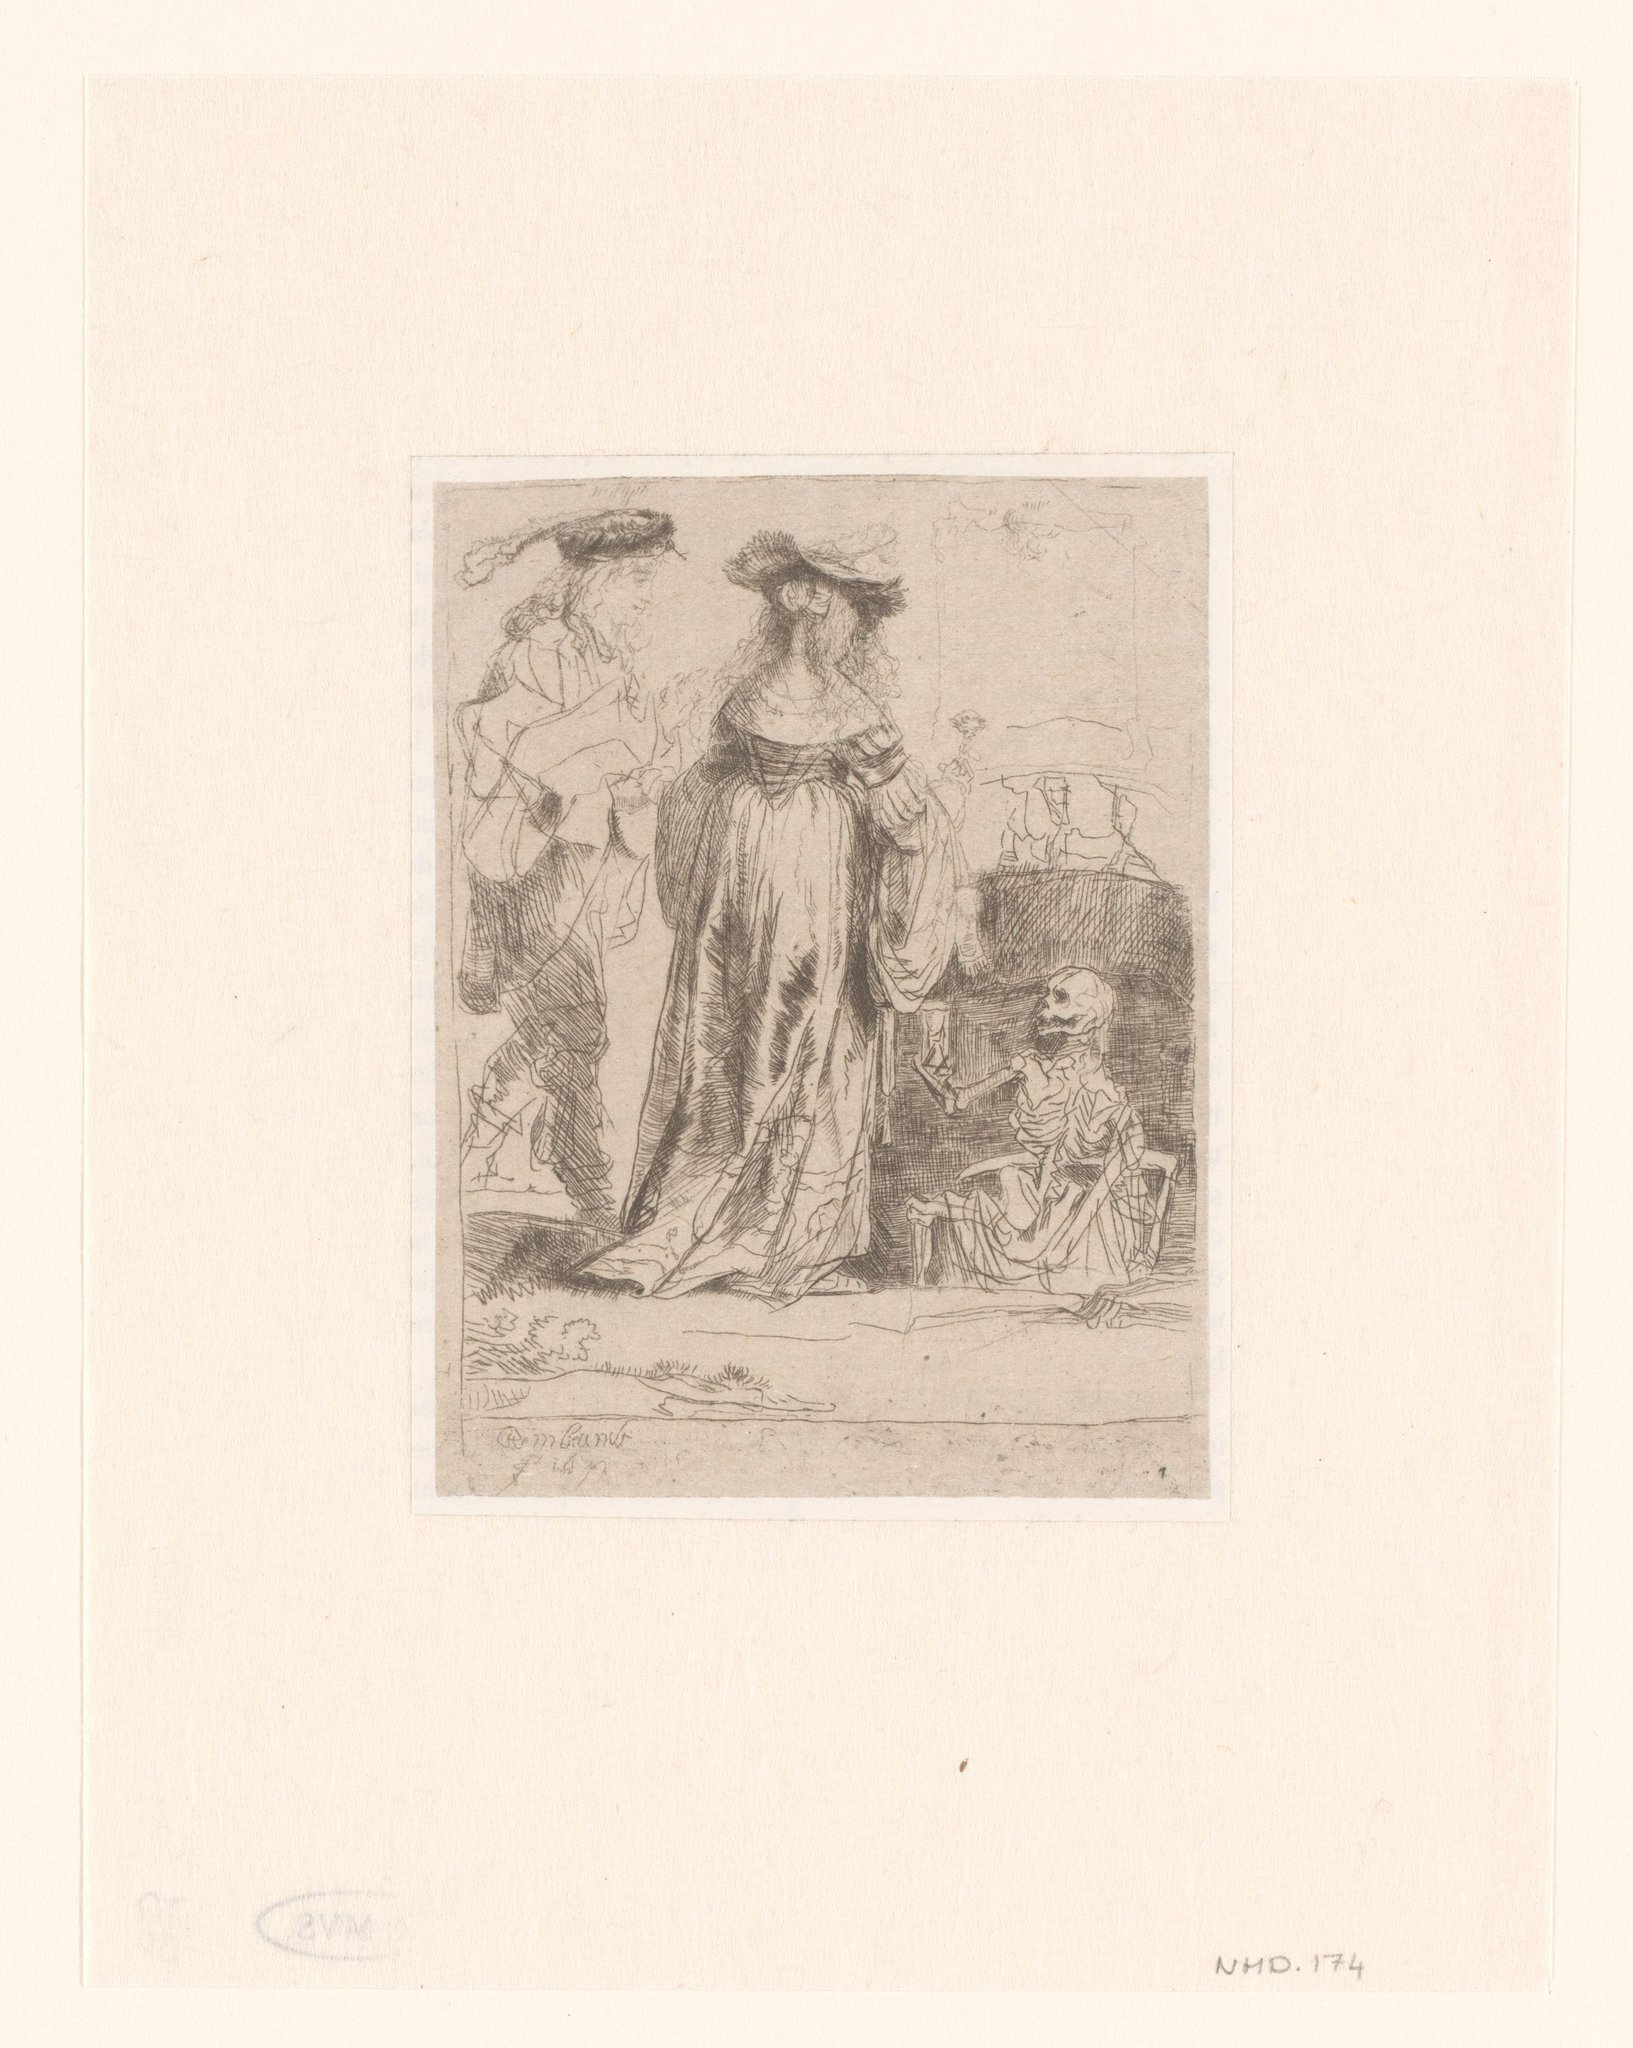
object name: print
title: Death appearing to a wedded couple from an open grave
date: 1859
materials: paper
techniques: etching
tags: dance of death; death together with one or more human beings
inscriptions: collector's mark: Lugt 2760, collector's mark: Lugt 2228